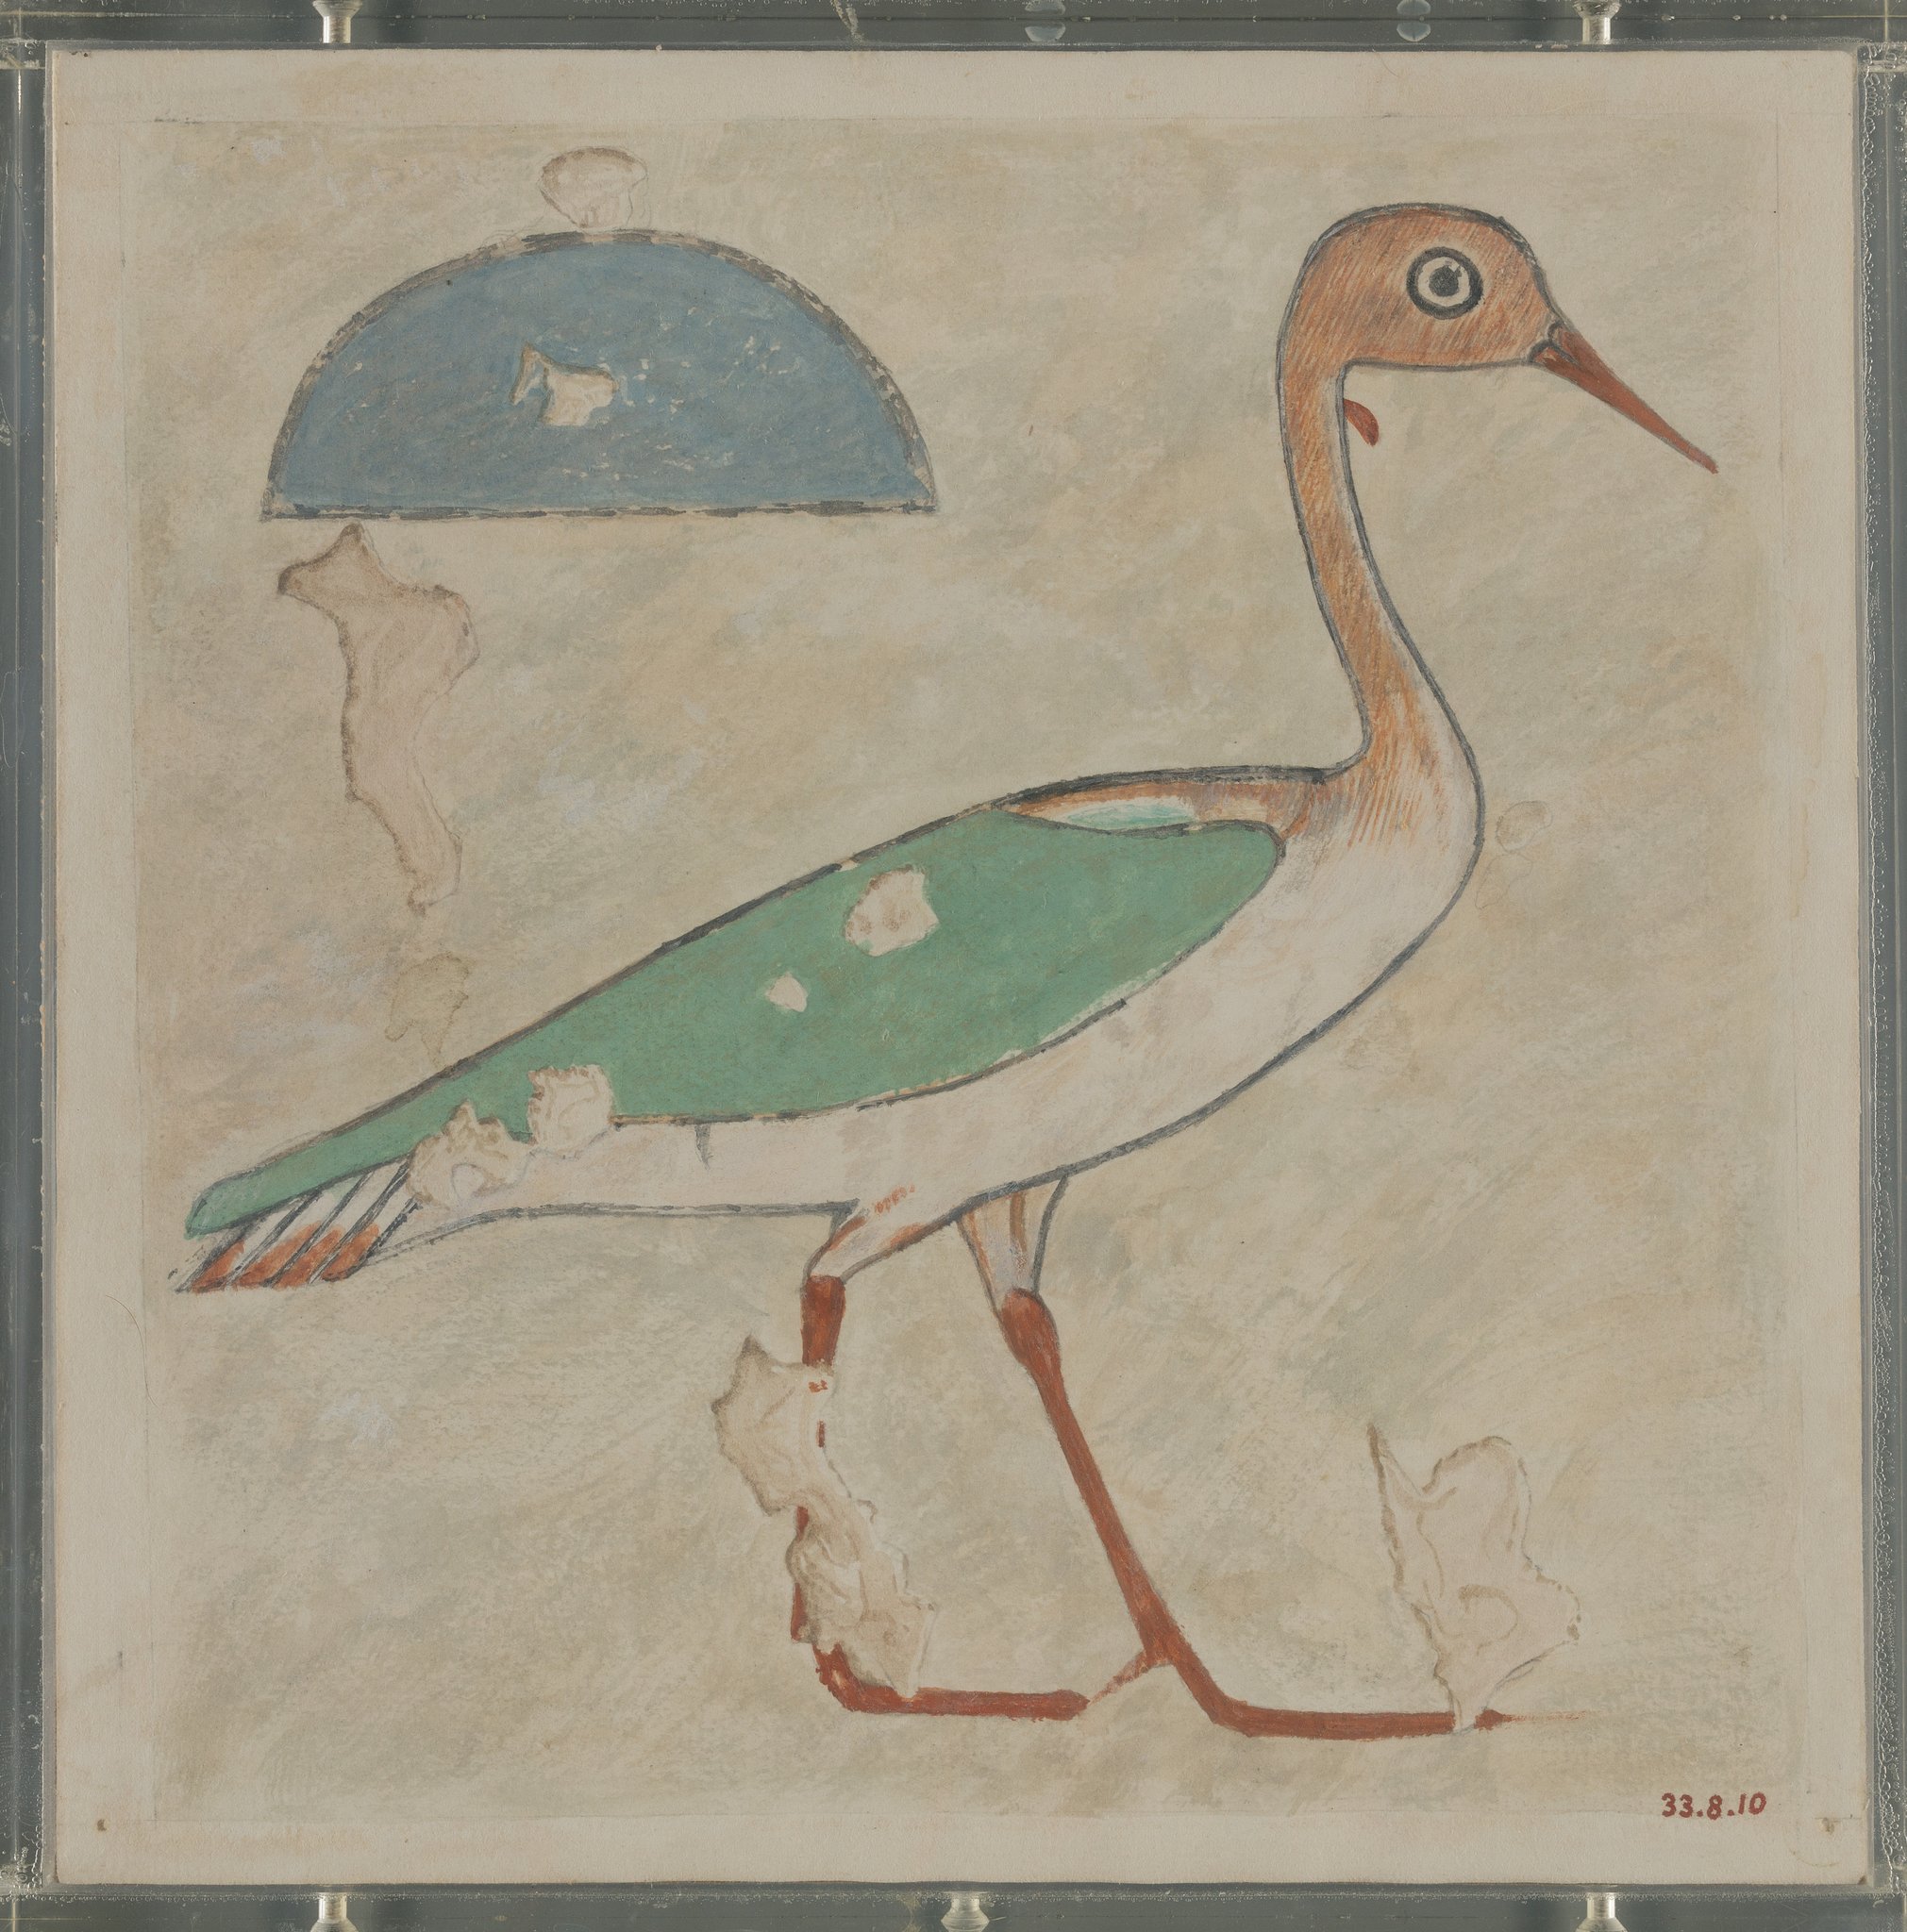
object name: facsimile, khnumhotep beni hasan 3, bird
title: Detail of a Bird, Tomb of Khnumhotep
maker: nina de garis davies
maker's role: artist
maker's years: 1881-1965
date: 1897-1878 BCE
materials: paper, paint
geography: egypt